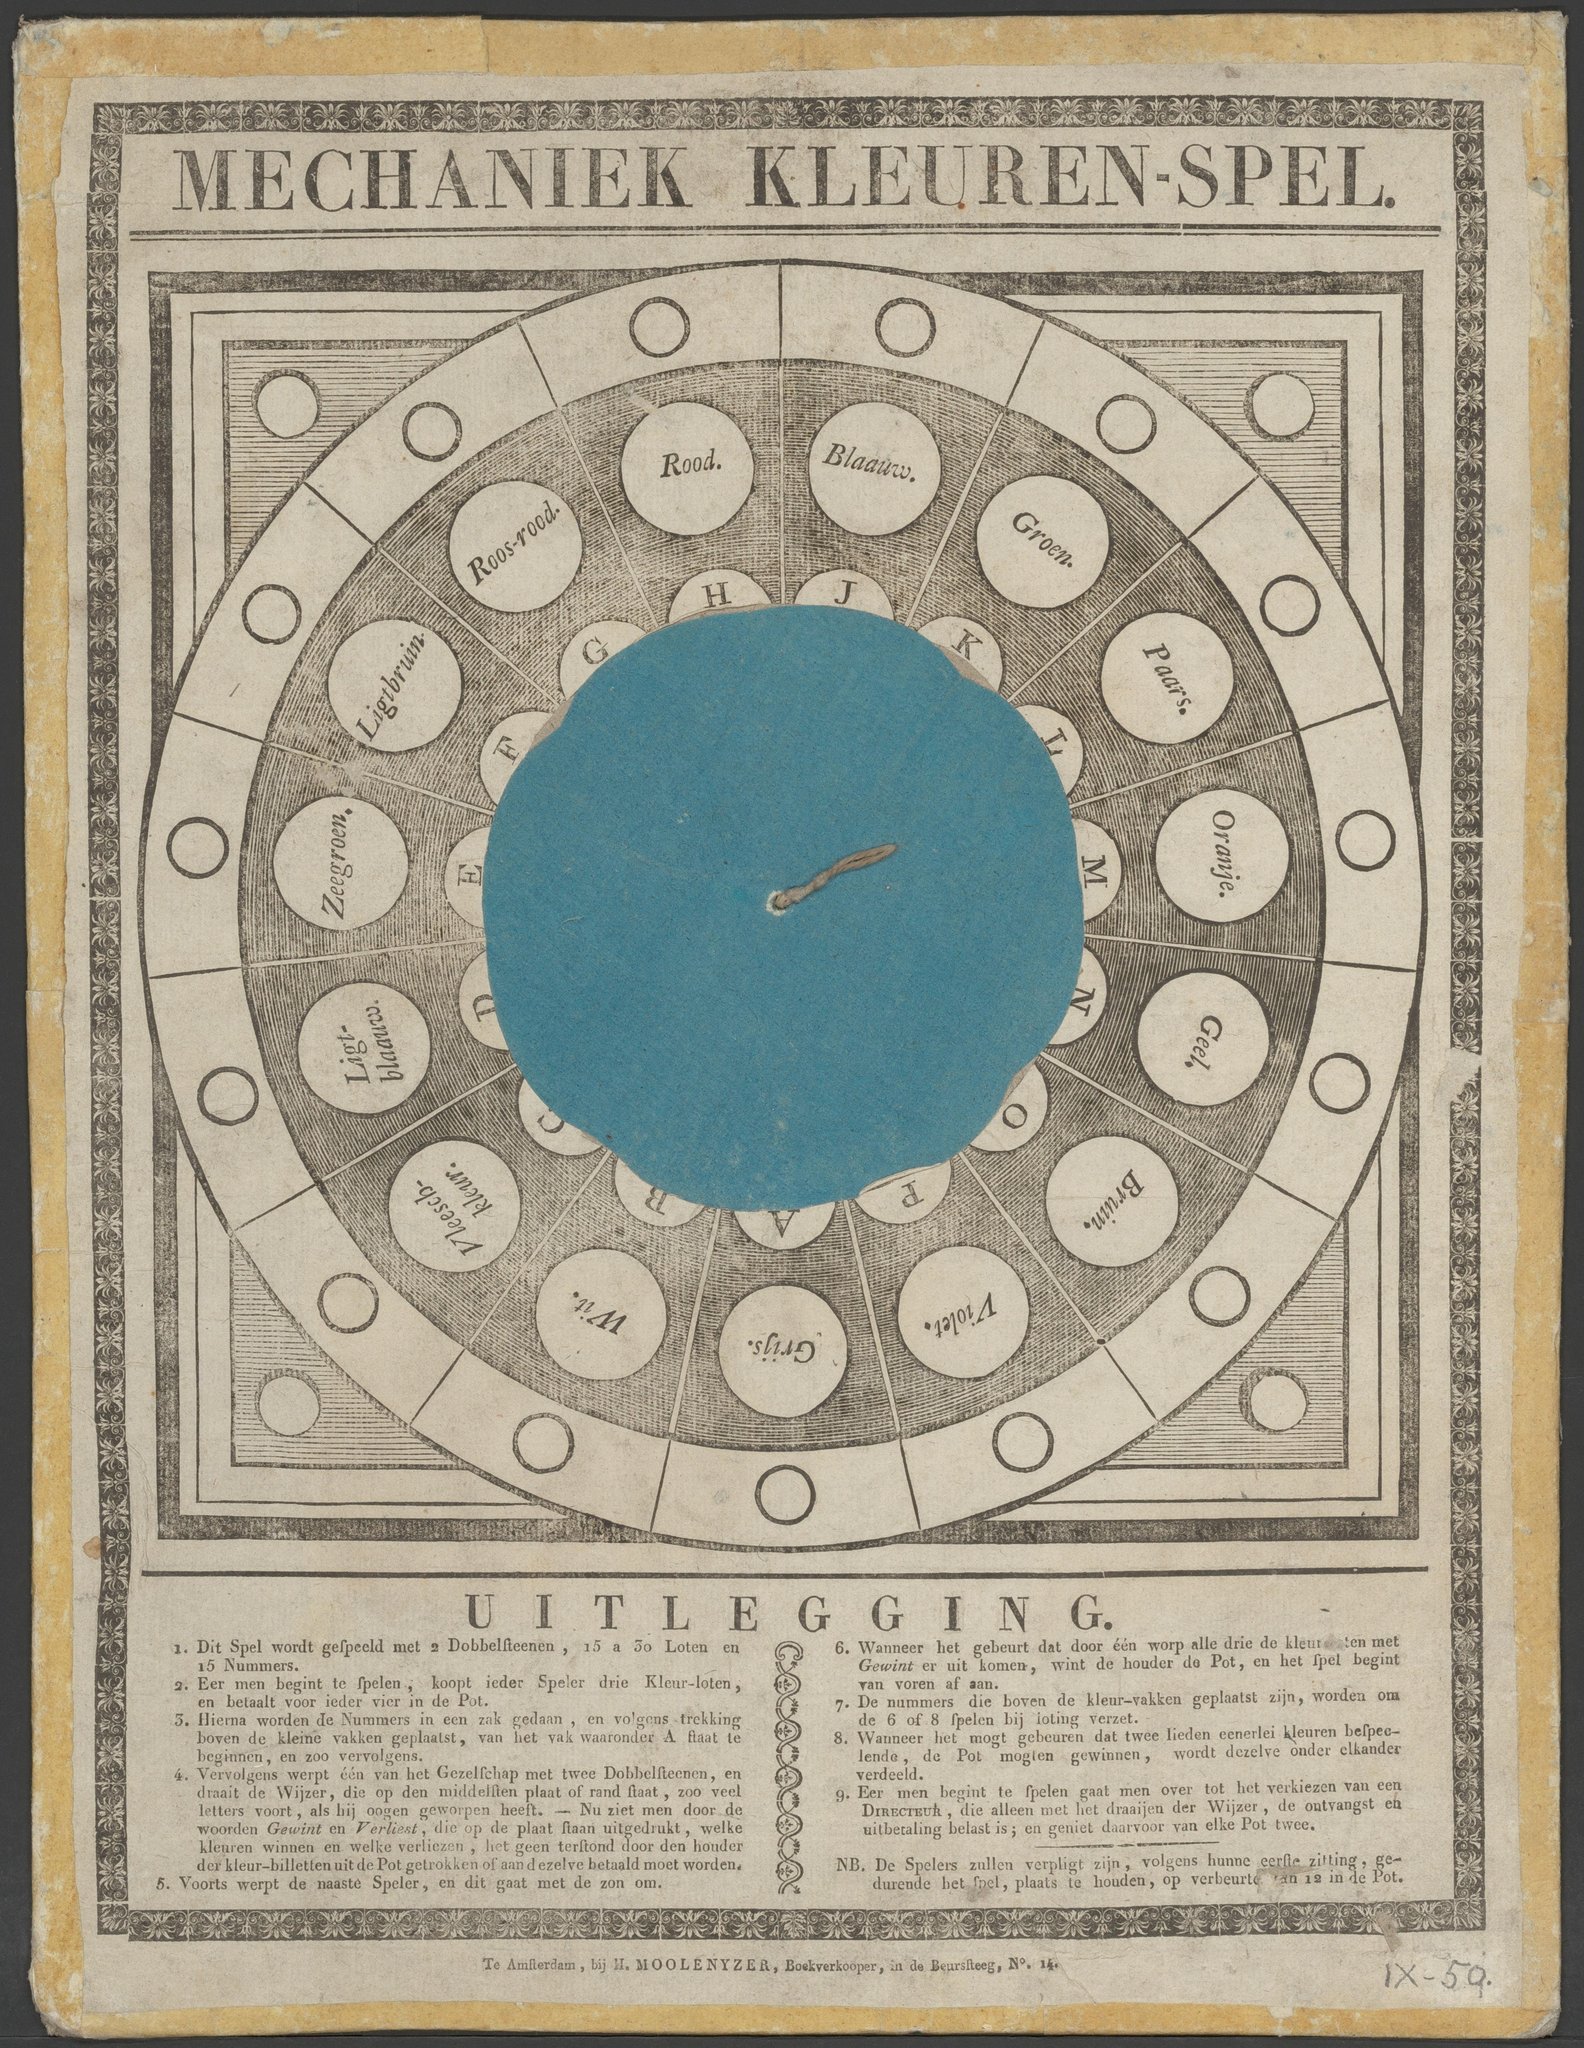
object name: print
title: Mechaniek kleuren-spel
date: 1816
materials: cardboard, paper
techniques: letterpress printing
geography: amsterdam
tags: board-games of chance, colours, pigments, and paints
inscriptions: collector's mark: Lugt 1641, collector's mark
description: Bordspel met binnen een vierkant een cirkel, verdeeld in 15 vakken die worden aangeduid met een kleuromschrijving. In dit exemplaar is het rozet in het midden van de cirkel beplakt met een blauw papier. In het midden hiervan een lusje van touw waaraan een wijzer bevestigd kon worden. Onder het spel staan de spelregels. Onderwerpsrubrieken binnen de Atlas Zeden en Gewoonten: Spel en Vermaak; gezelschapsspel, ganzenbord en dergelijke.